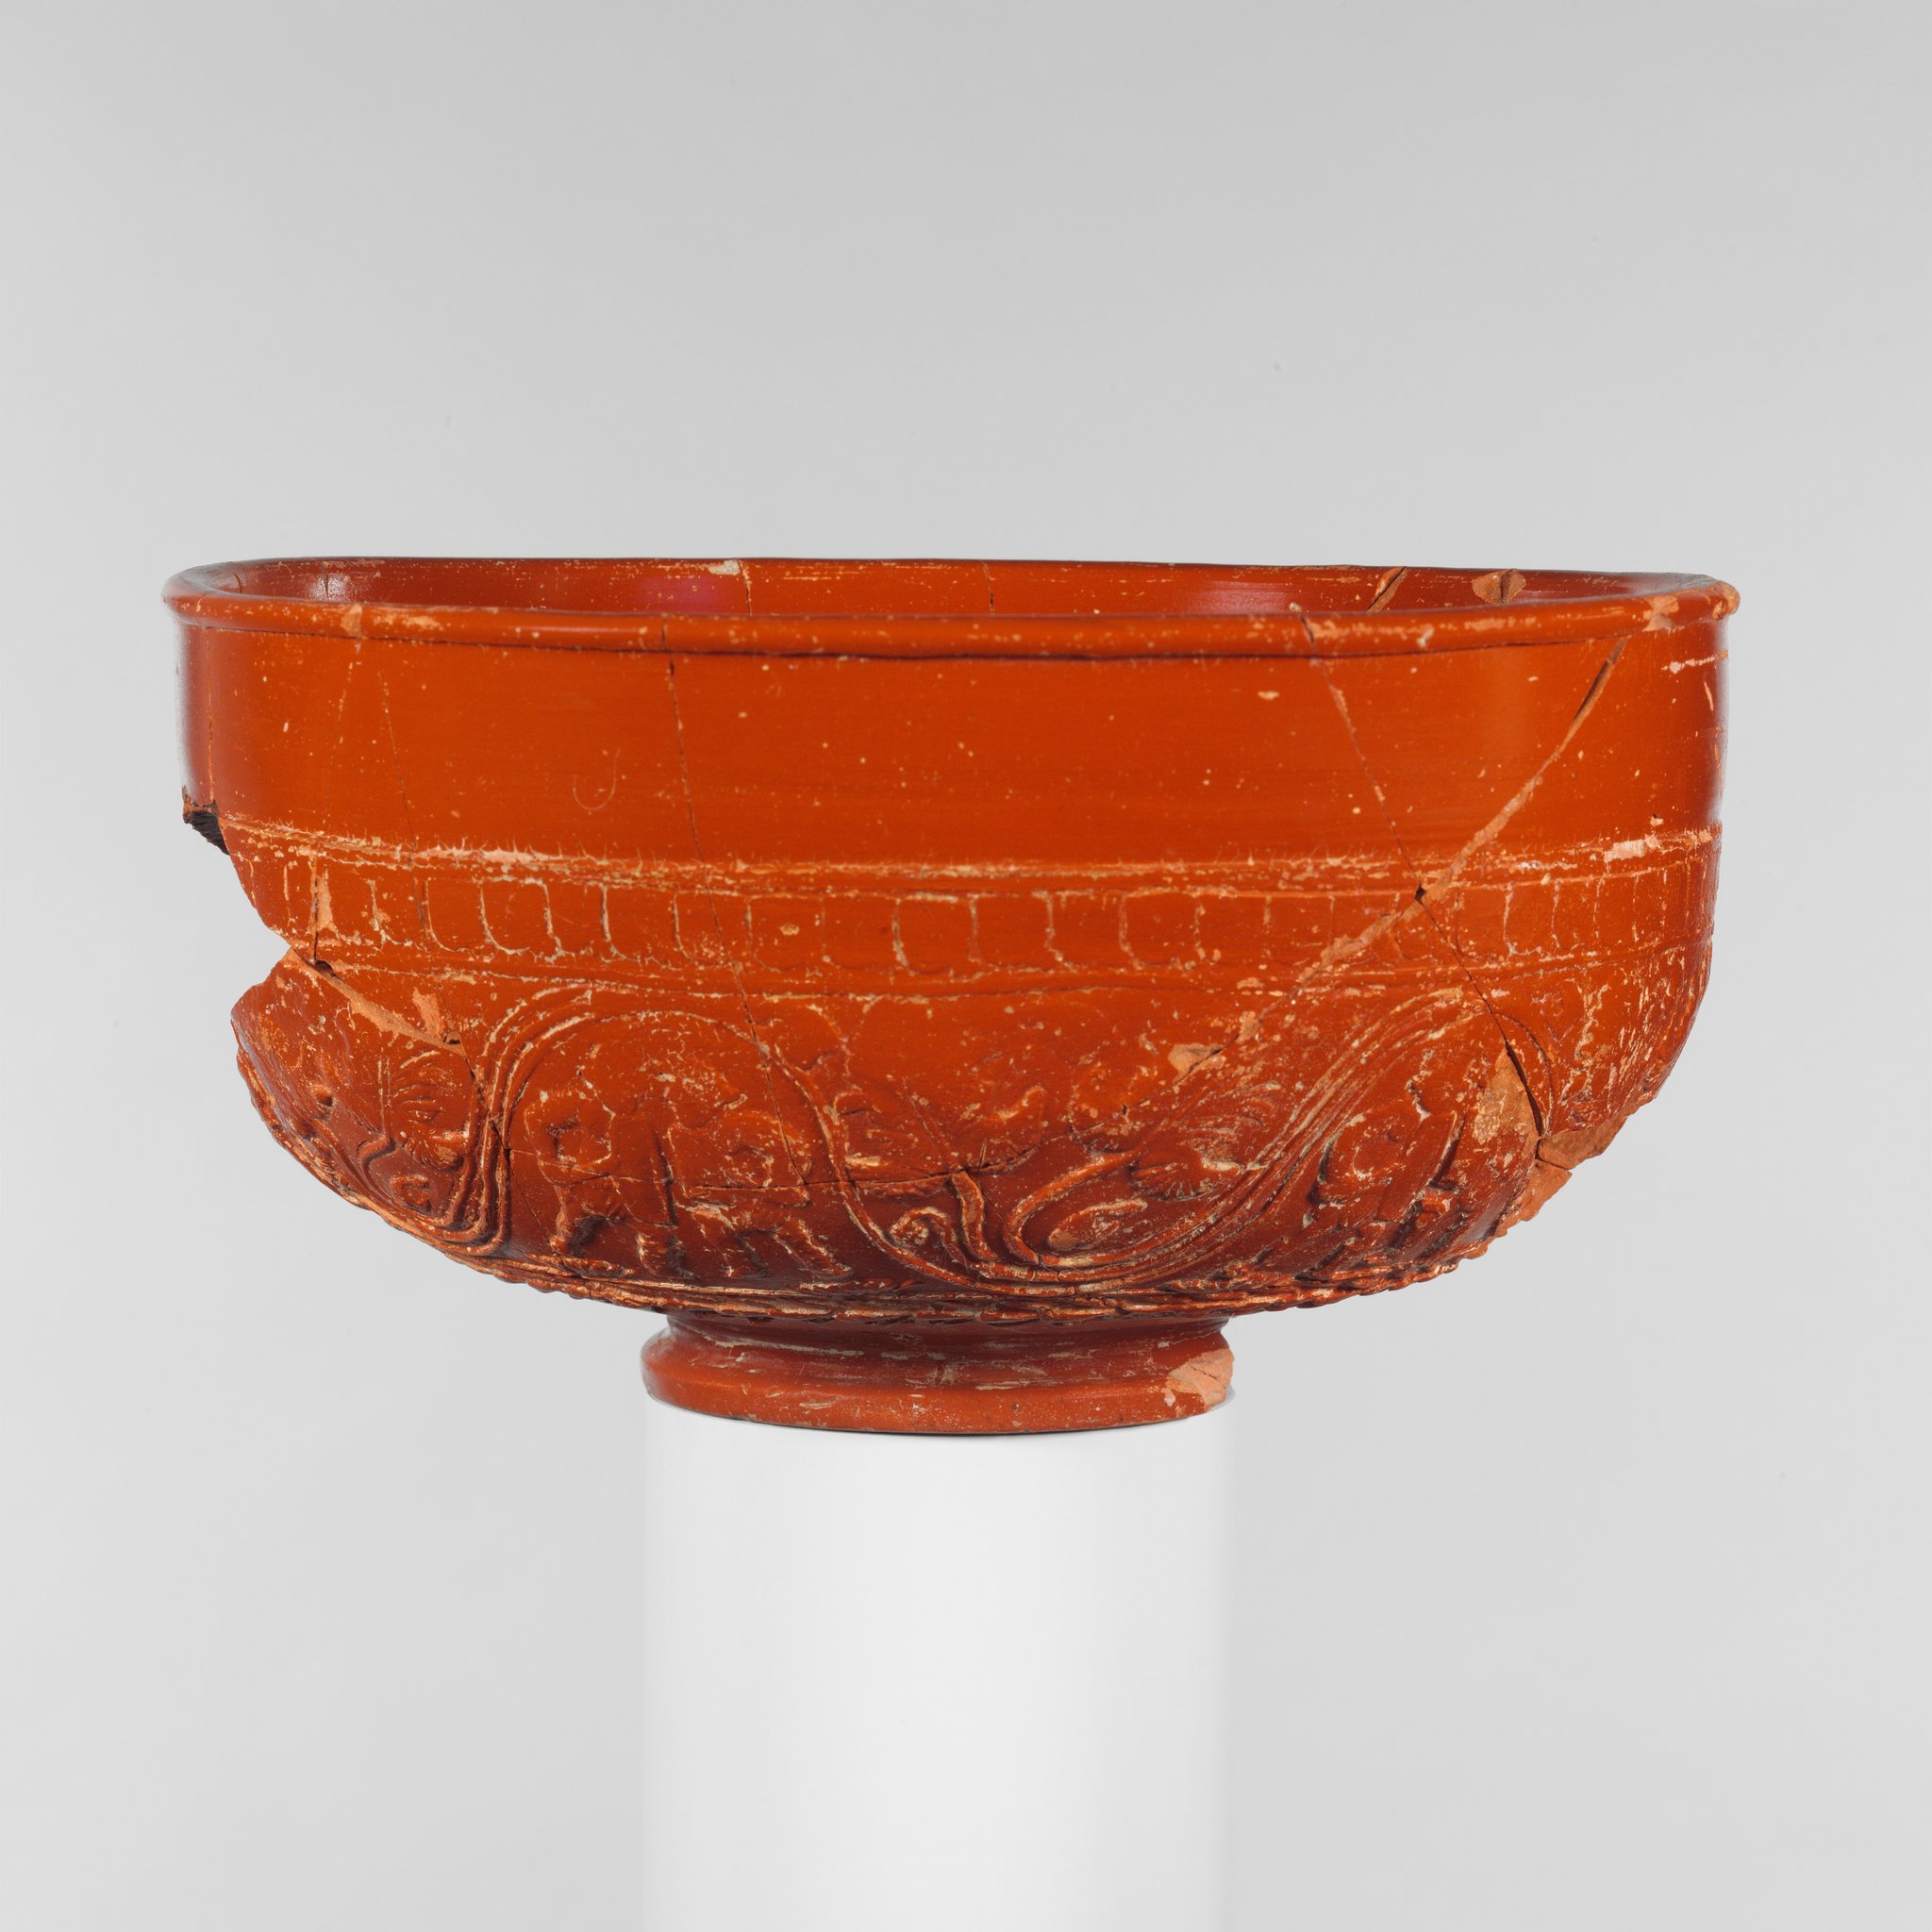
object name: bowl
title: Terracotta bowl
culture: roman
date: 90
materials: terracotta